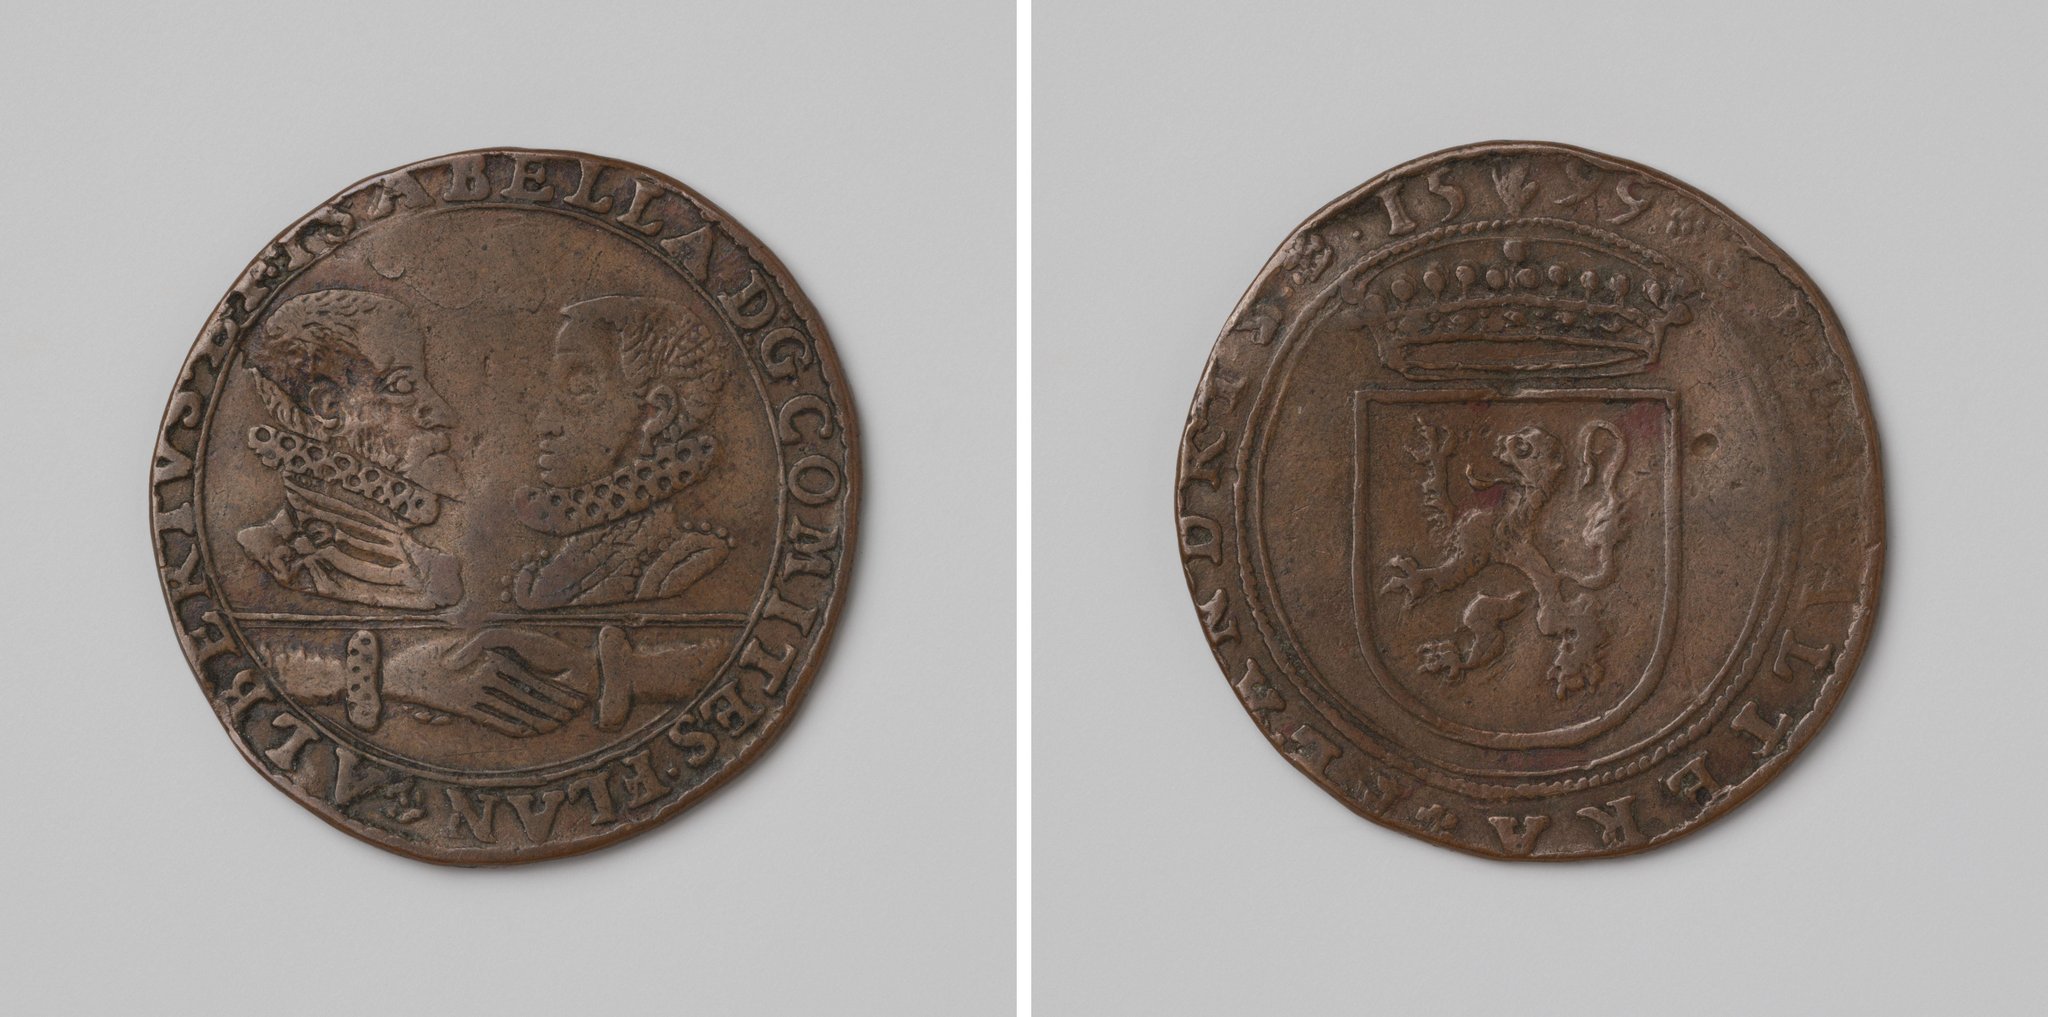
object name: jeton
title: Huwelijk van Albrecht en Isabella van Oostenrijk te Valencia, rekenpenning geslagen op last van de Staten van Vlaanderen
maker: Anonymous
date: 1599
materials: copper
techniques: striking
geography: antwerp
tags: infante van spanje isabella clara eugenia, brussels, albrecht aartshertog van oostenrijk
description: Koperen penning. Voorzijde: naar elkaar gewende borststukken van man en vrouw binnen omschrift; afsnede: twee ineen geslagen handen. Keerzijde: gekroond wapenschild binnen omschrift